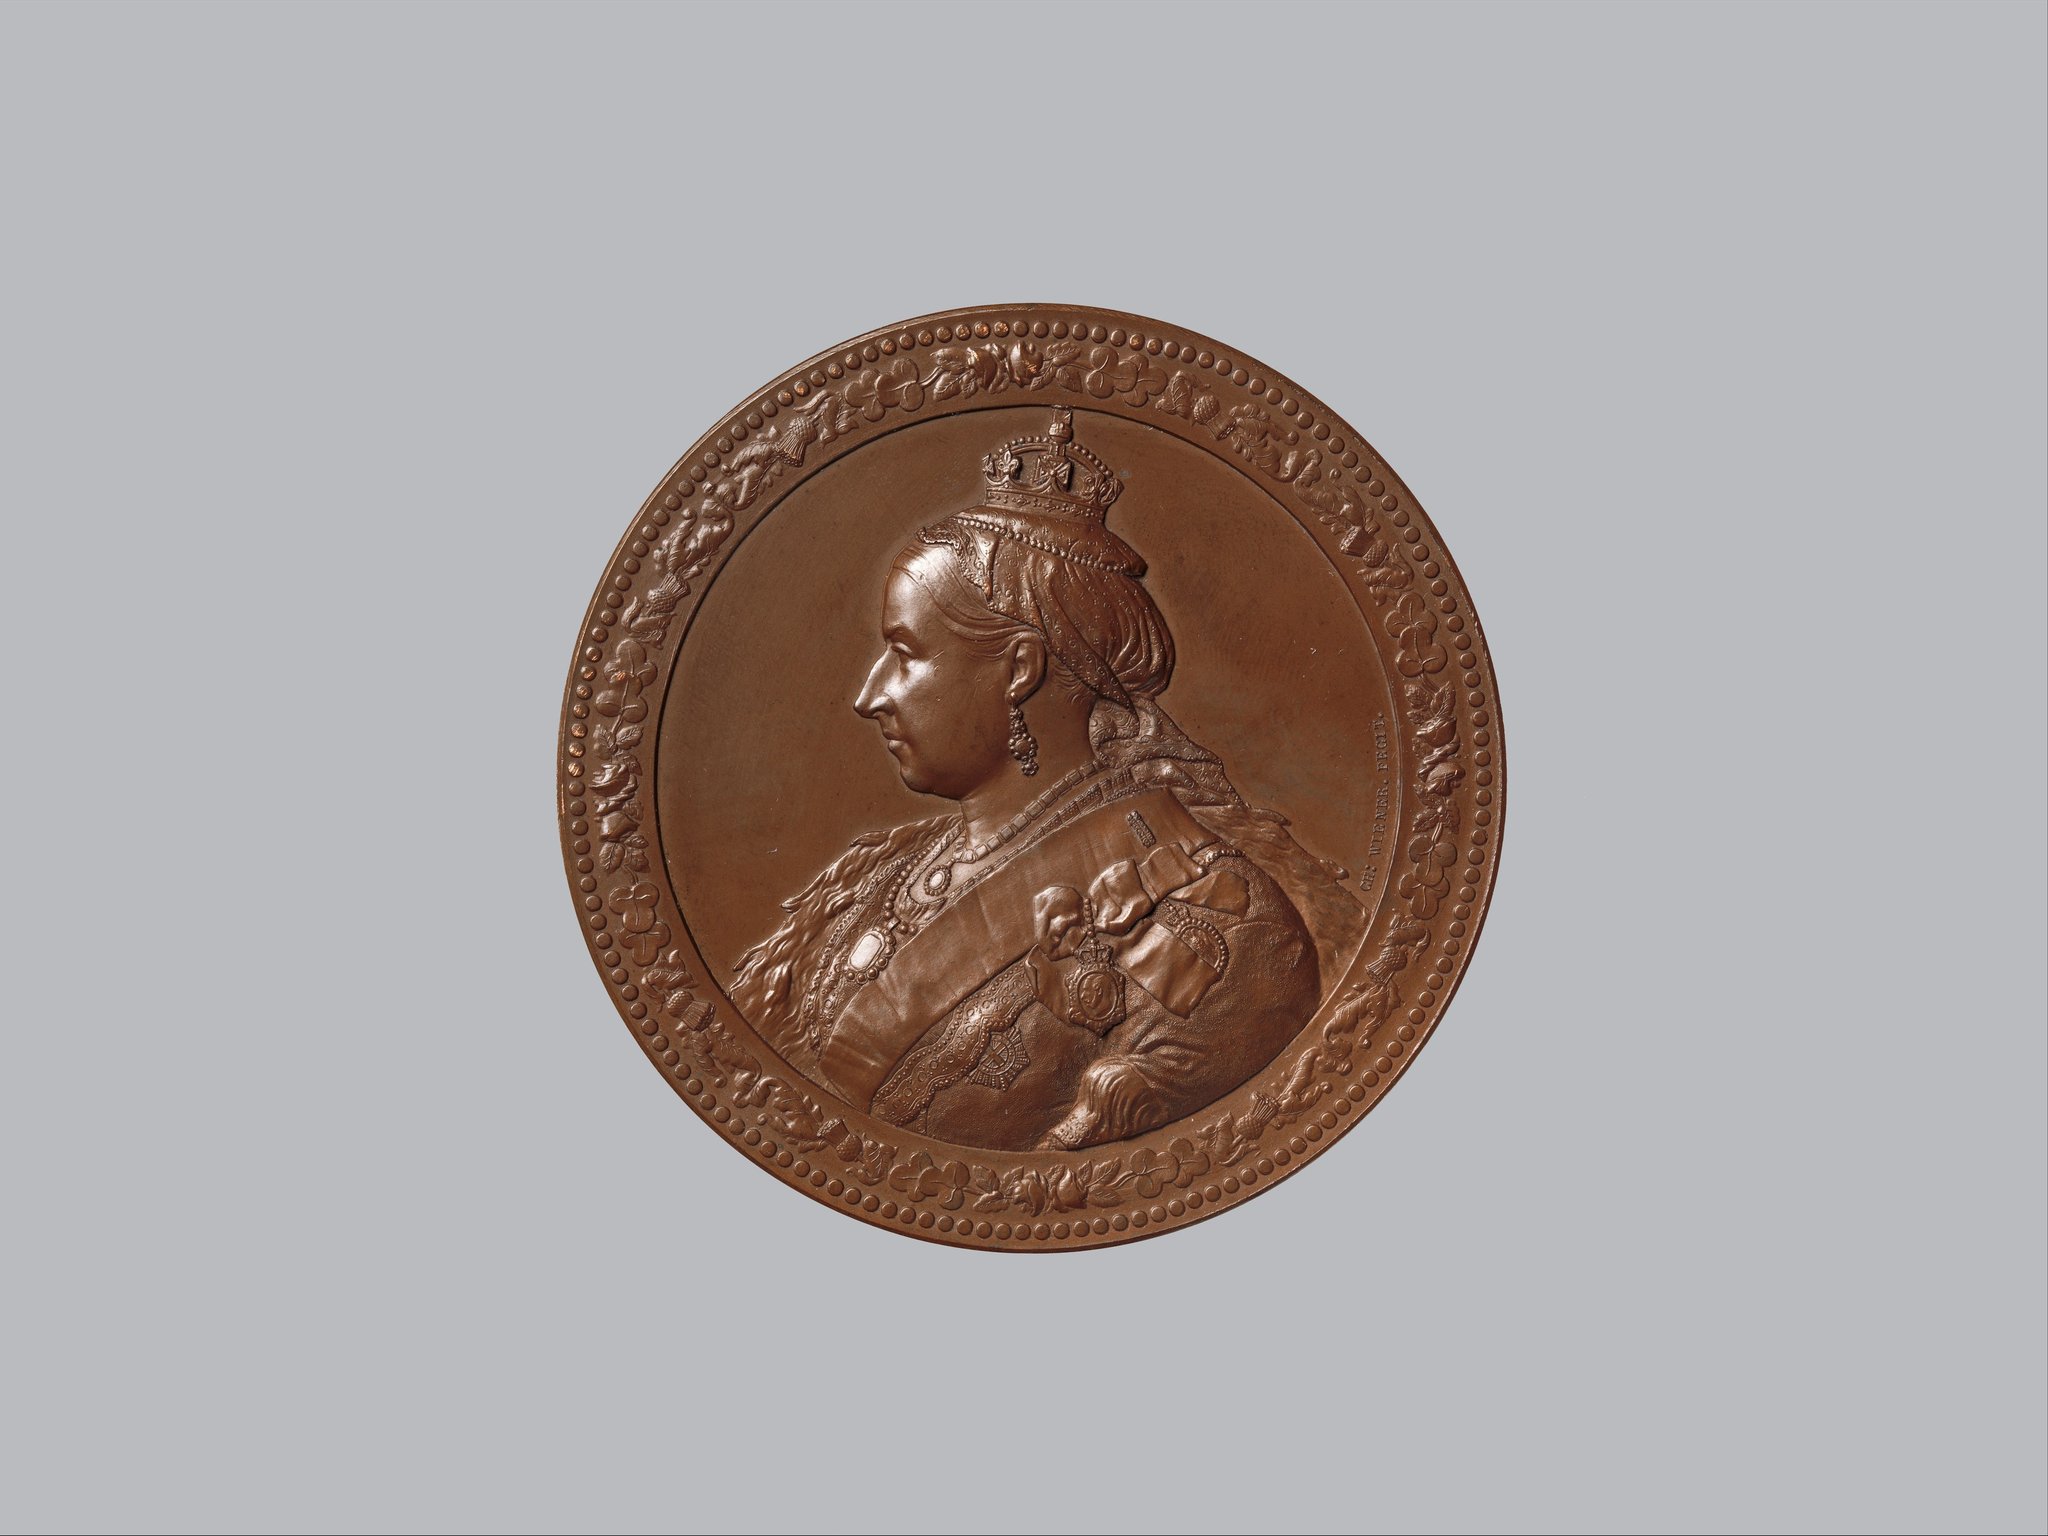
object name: medal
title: The Opening to the Public of the Royal Forest of Epping, May, 1882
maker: charles wiener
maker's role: artist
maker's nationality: belgian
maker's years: 1832-1887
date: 1882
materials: bronze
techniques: struck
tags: profiles,women